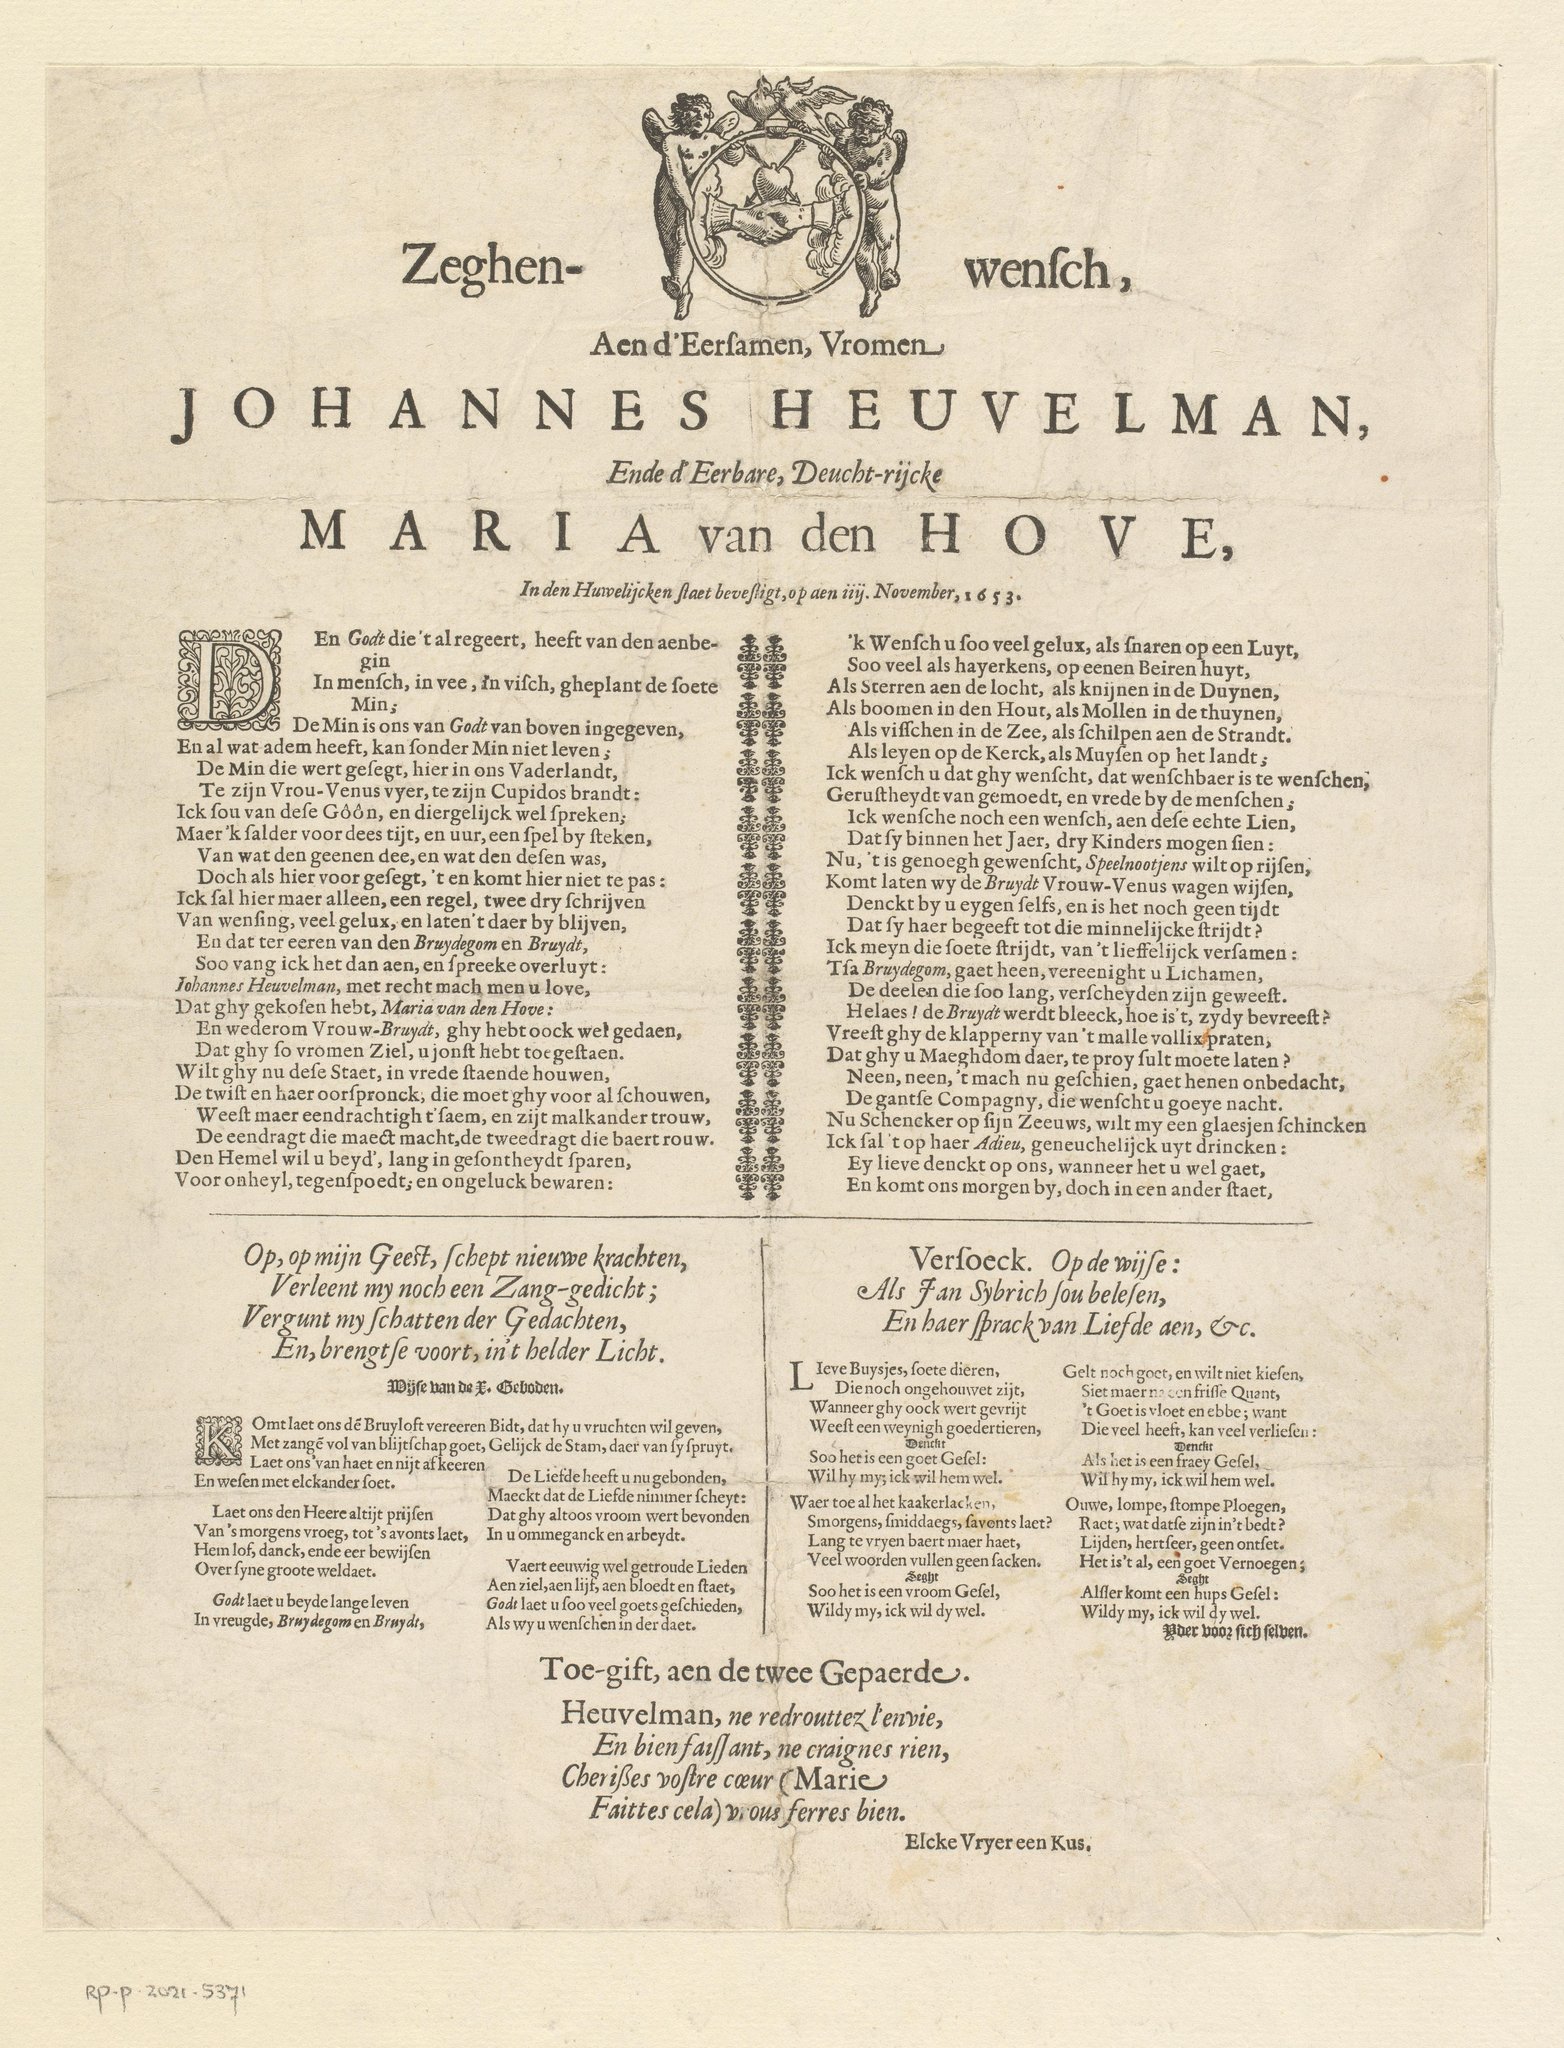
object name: marriage print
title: Huwelijksgedicht voor Johannes Heuvelman en Maria van den Hove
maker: Anonymous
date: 1653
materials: paper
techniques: letterpress printing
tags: (civil) marriage ceremonies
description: Huwelijksgedicht voor het huwelijk dat op 3 november 1653 werd voltrokken. Bovenaan een vignet van twee engelen die een medaillon dragen waarop twee handen schudden onder een door twee pijlen doorboord hart. Bovenop het medaillon nog twee duiven.